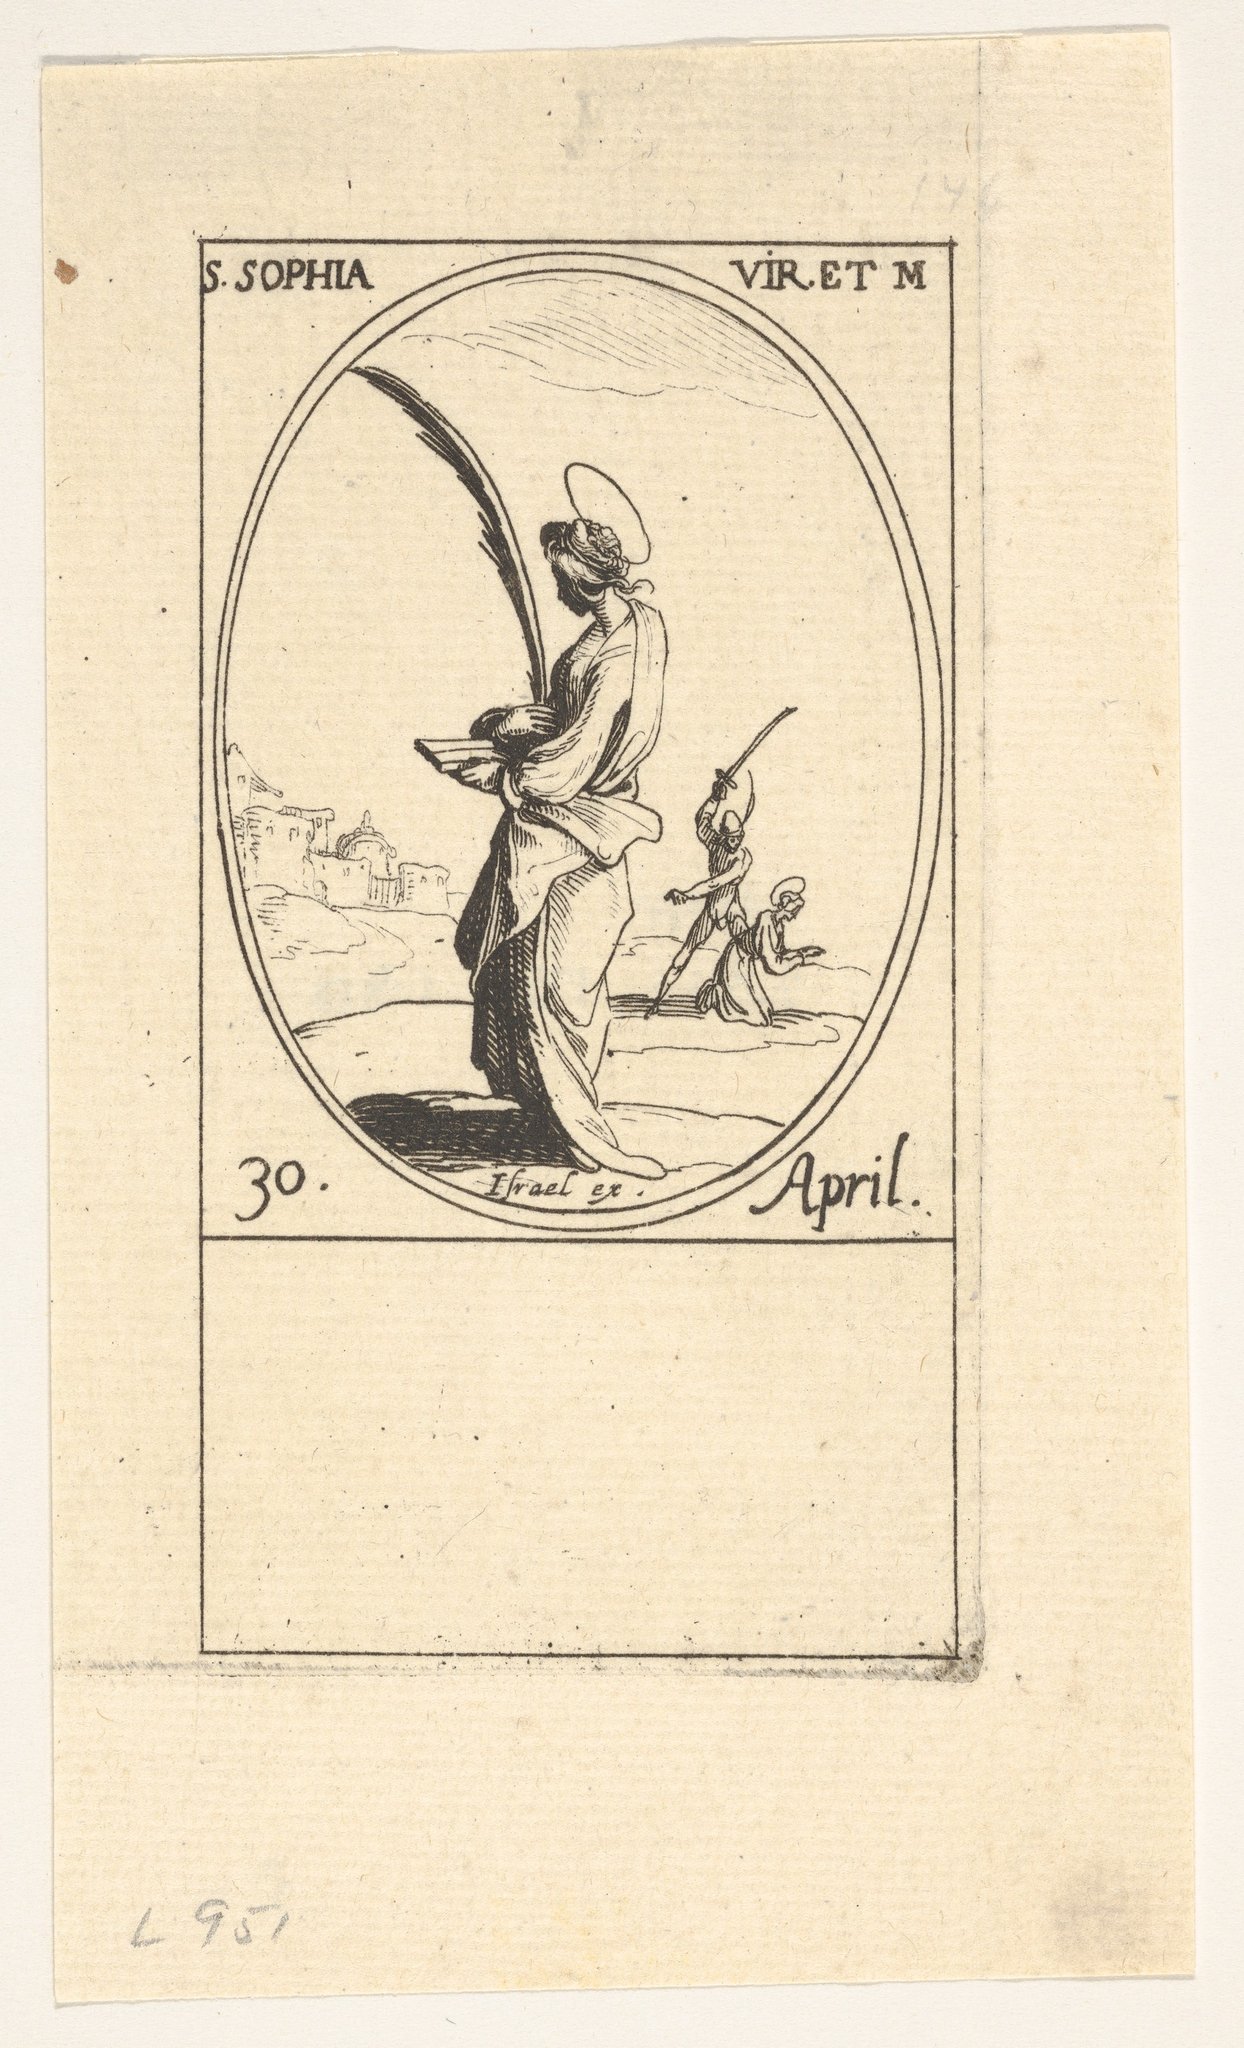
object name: print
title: Martyrdom of Saint Sophia, an oval composition, from "Les images de tous les saints et saintes de l'année" (Images of all the saints of the year)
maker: jacques callot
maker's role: artist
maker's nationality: french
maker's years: 1592-1635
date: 1632-1635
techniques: etching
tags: profiles,women,saints